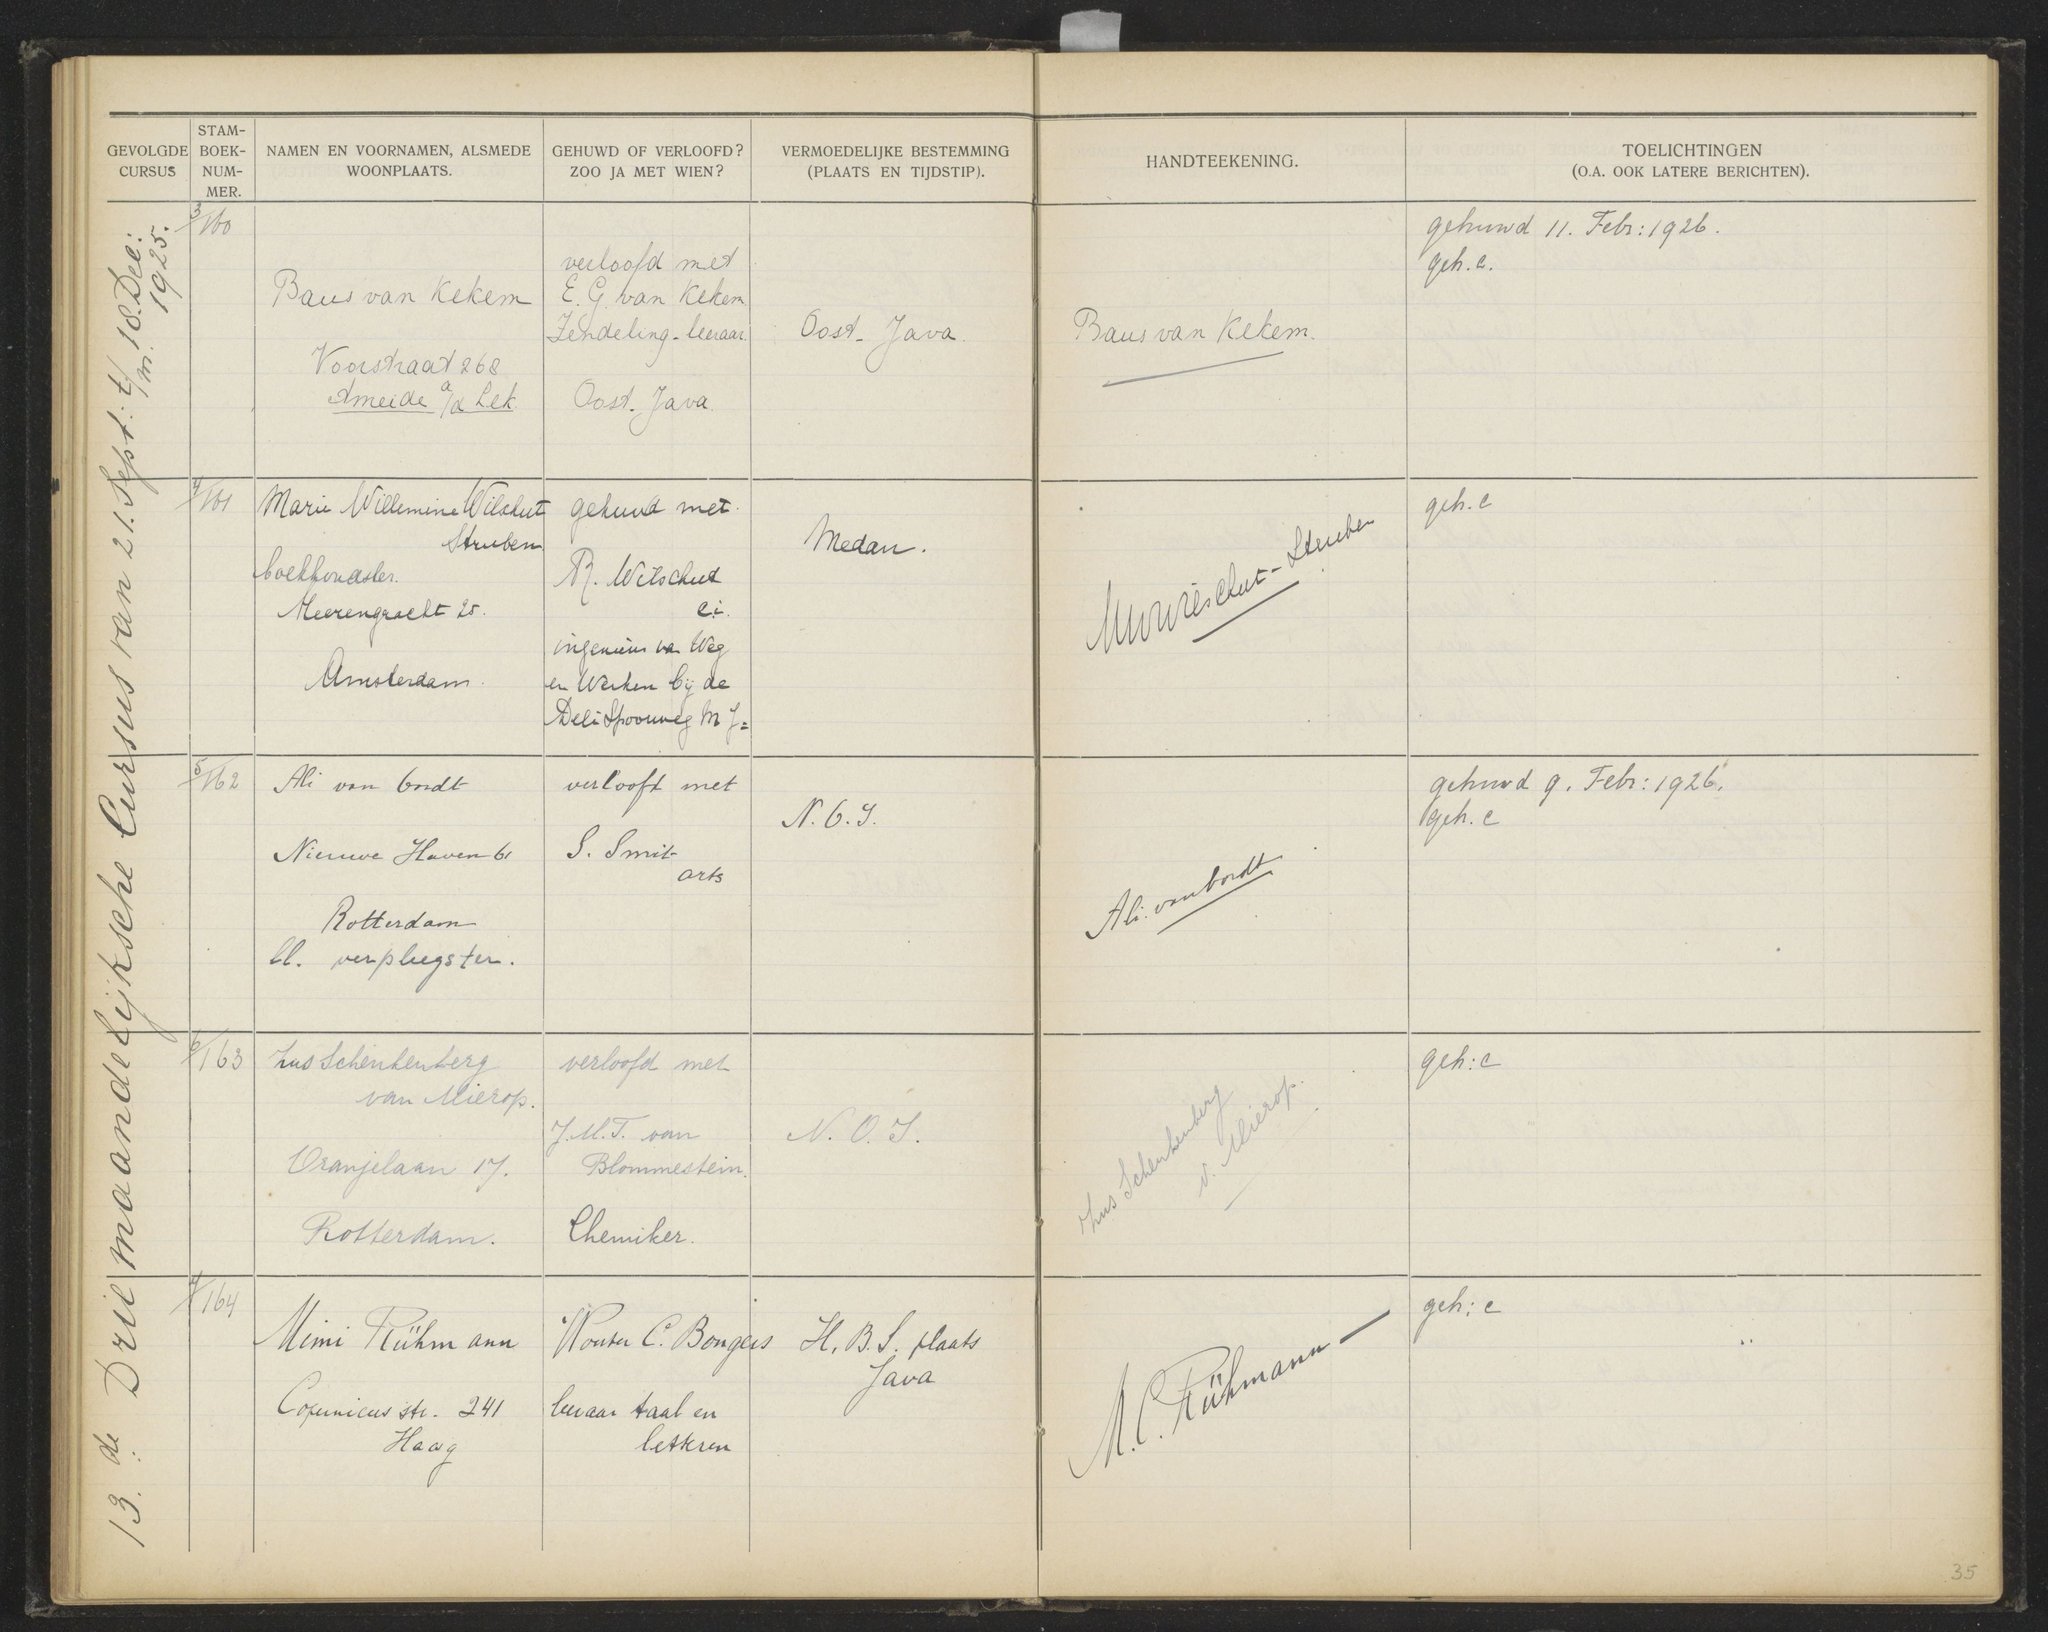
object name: album leaf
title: Blad 35 uit Stamboek van de leerlingen der Koloniale School voor Meisjes en Vrouwen te 's-Gravenhage deel I (1921-1929)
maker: Anonymous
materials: paper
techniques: printing, writing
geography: the hague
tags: further education (+ pupil), further education, the hague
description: Twee pagina's met gegevens van de deelnemers aan de 13e driemaandelijkse cursus van 21 september tot en met 18 december 1925, stamboeknummers 160 tot en met 164. Onderdeel van Stamboek van de leerlingen der Koloniale School voor Meisjes en Vrouwen te 's-Gravenhage deel I (1921-1929).